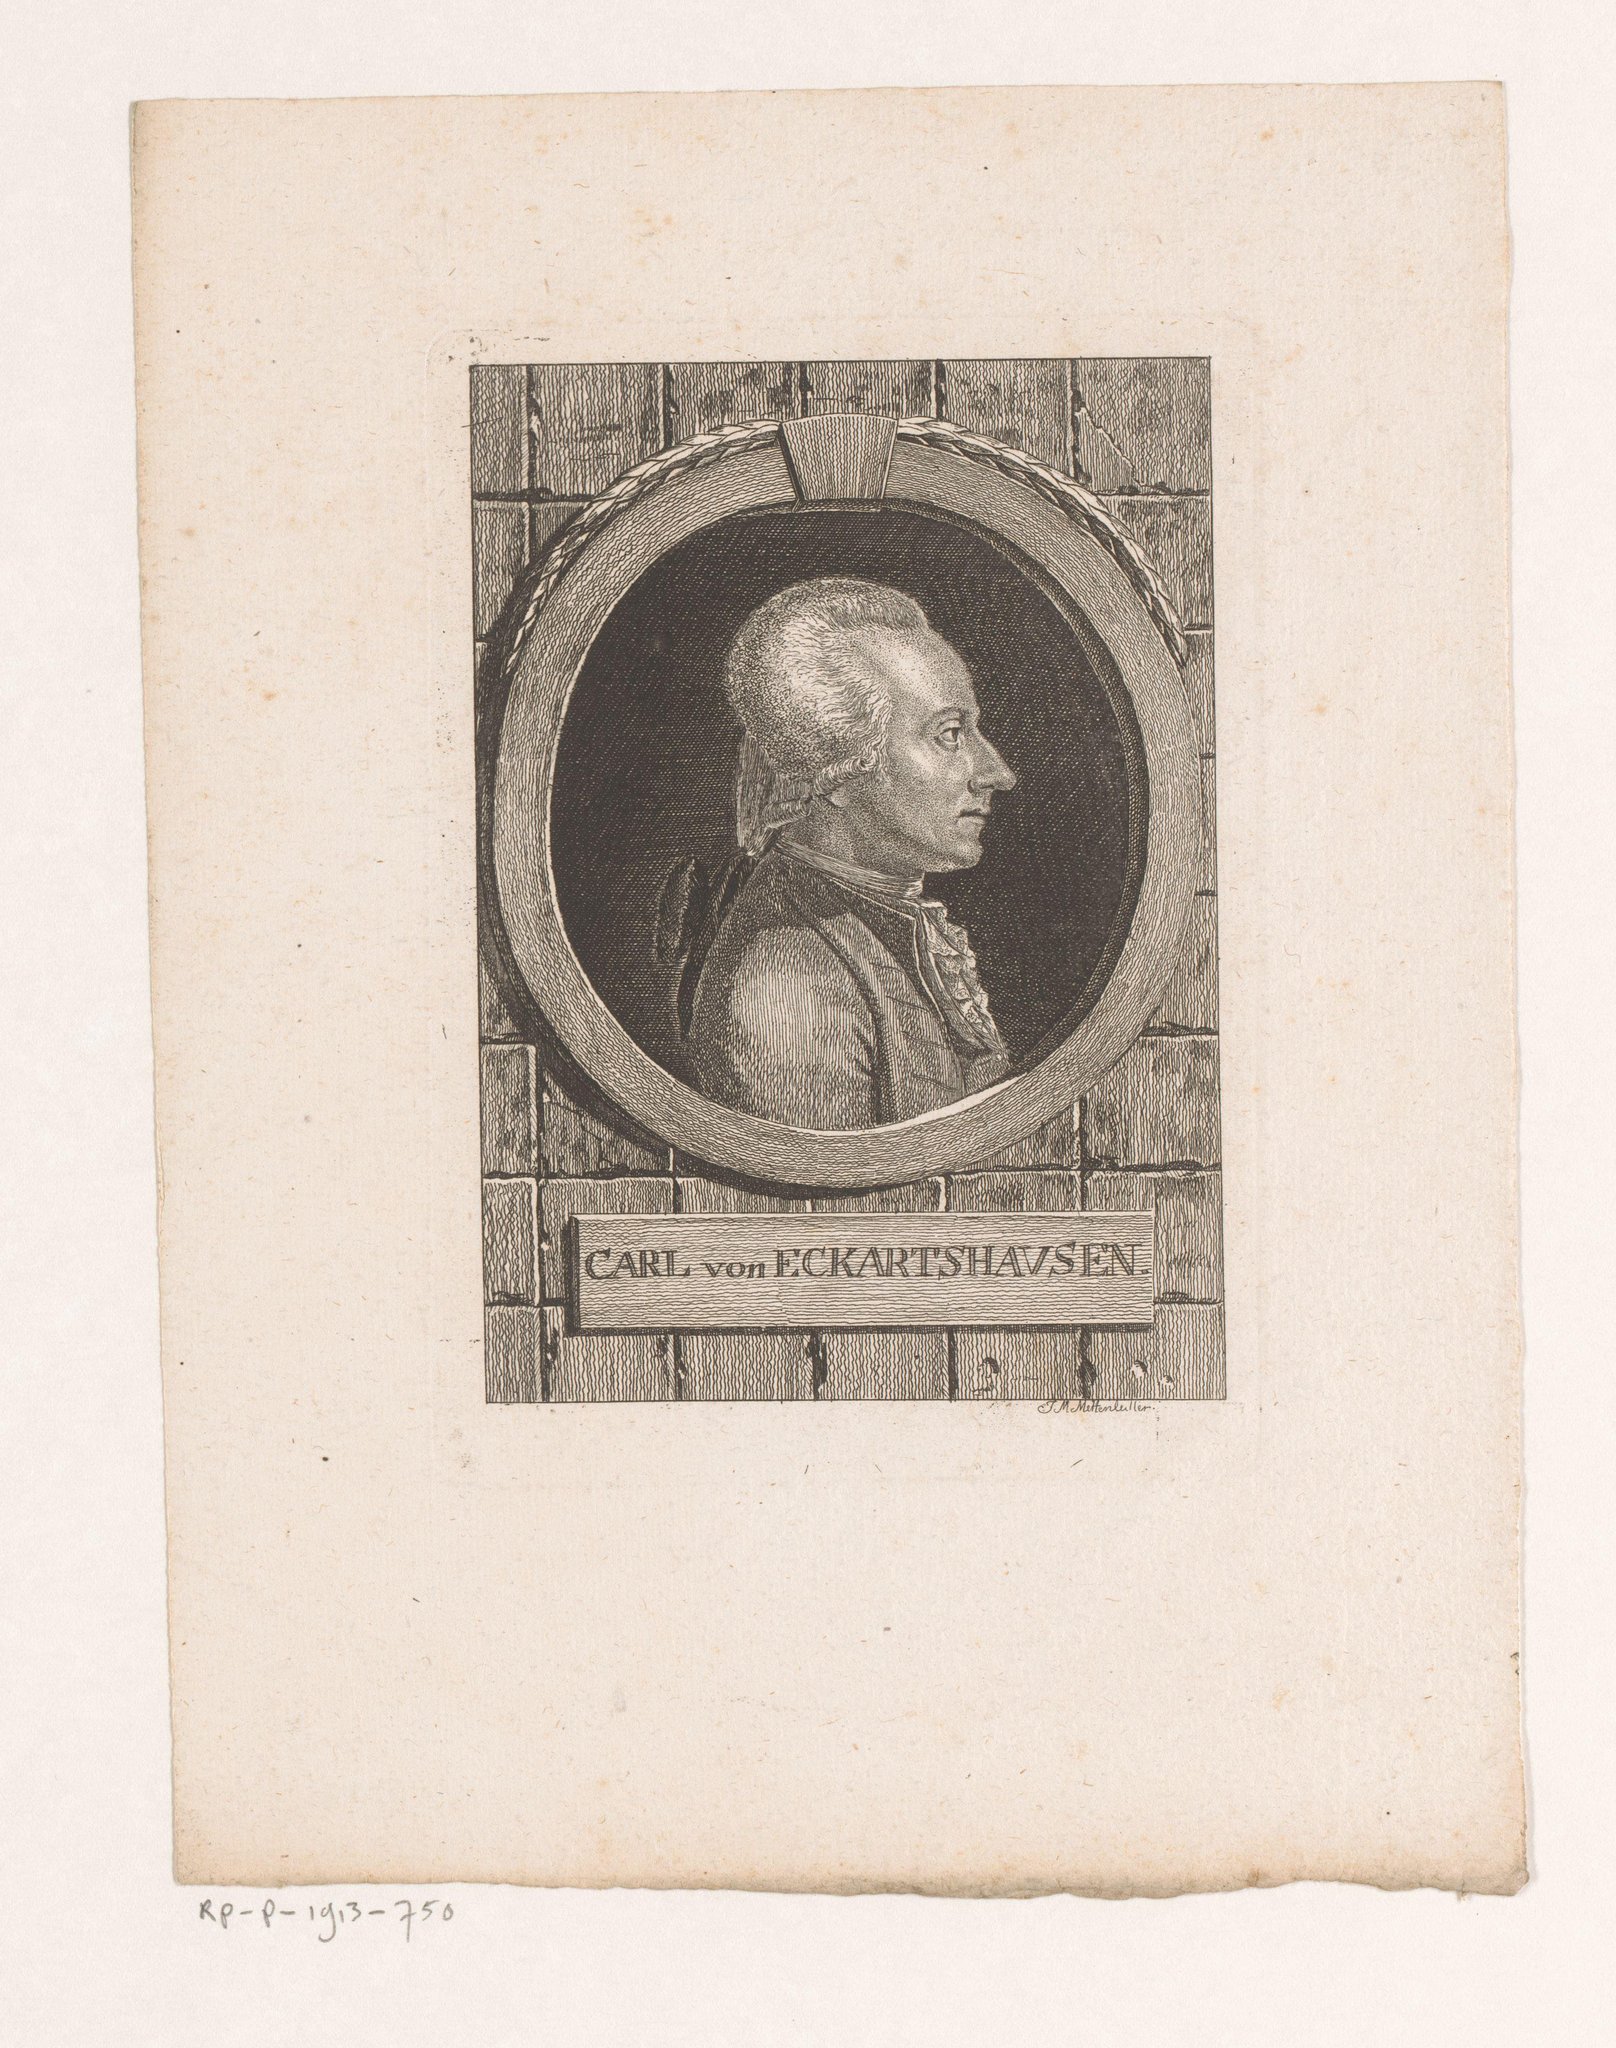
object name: print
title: Portret van Karl von Eckartshausen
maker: johann michael mettenleiter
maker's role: print maker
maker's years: 1765-1853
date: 1775-1853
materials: paper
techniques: etching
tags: historical persons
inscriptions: collector's mark: Lugt 2228